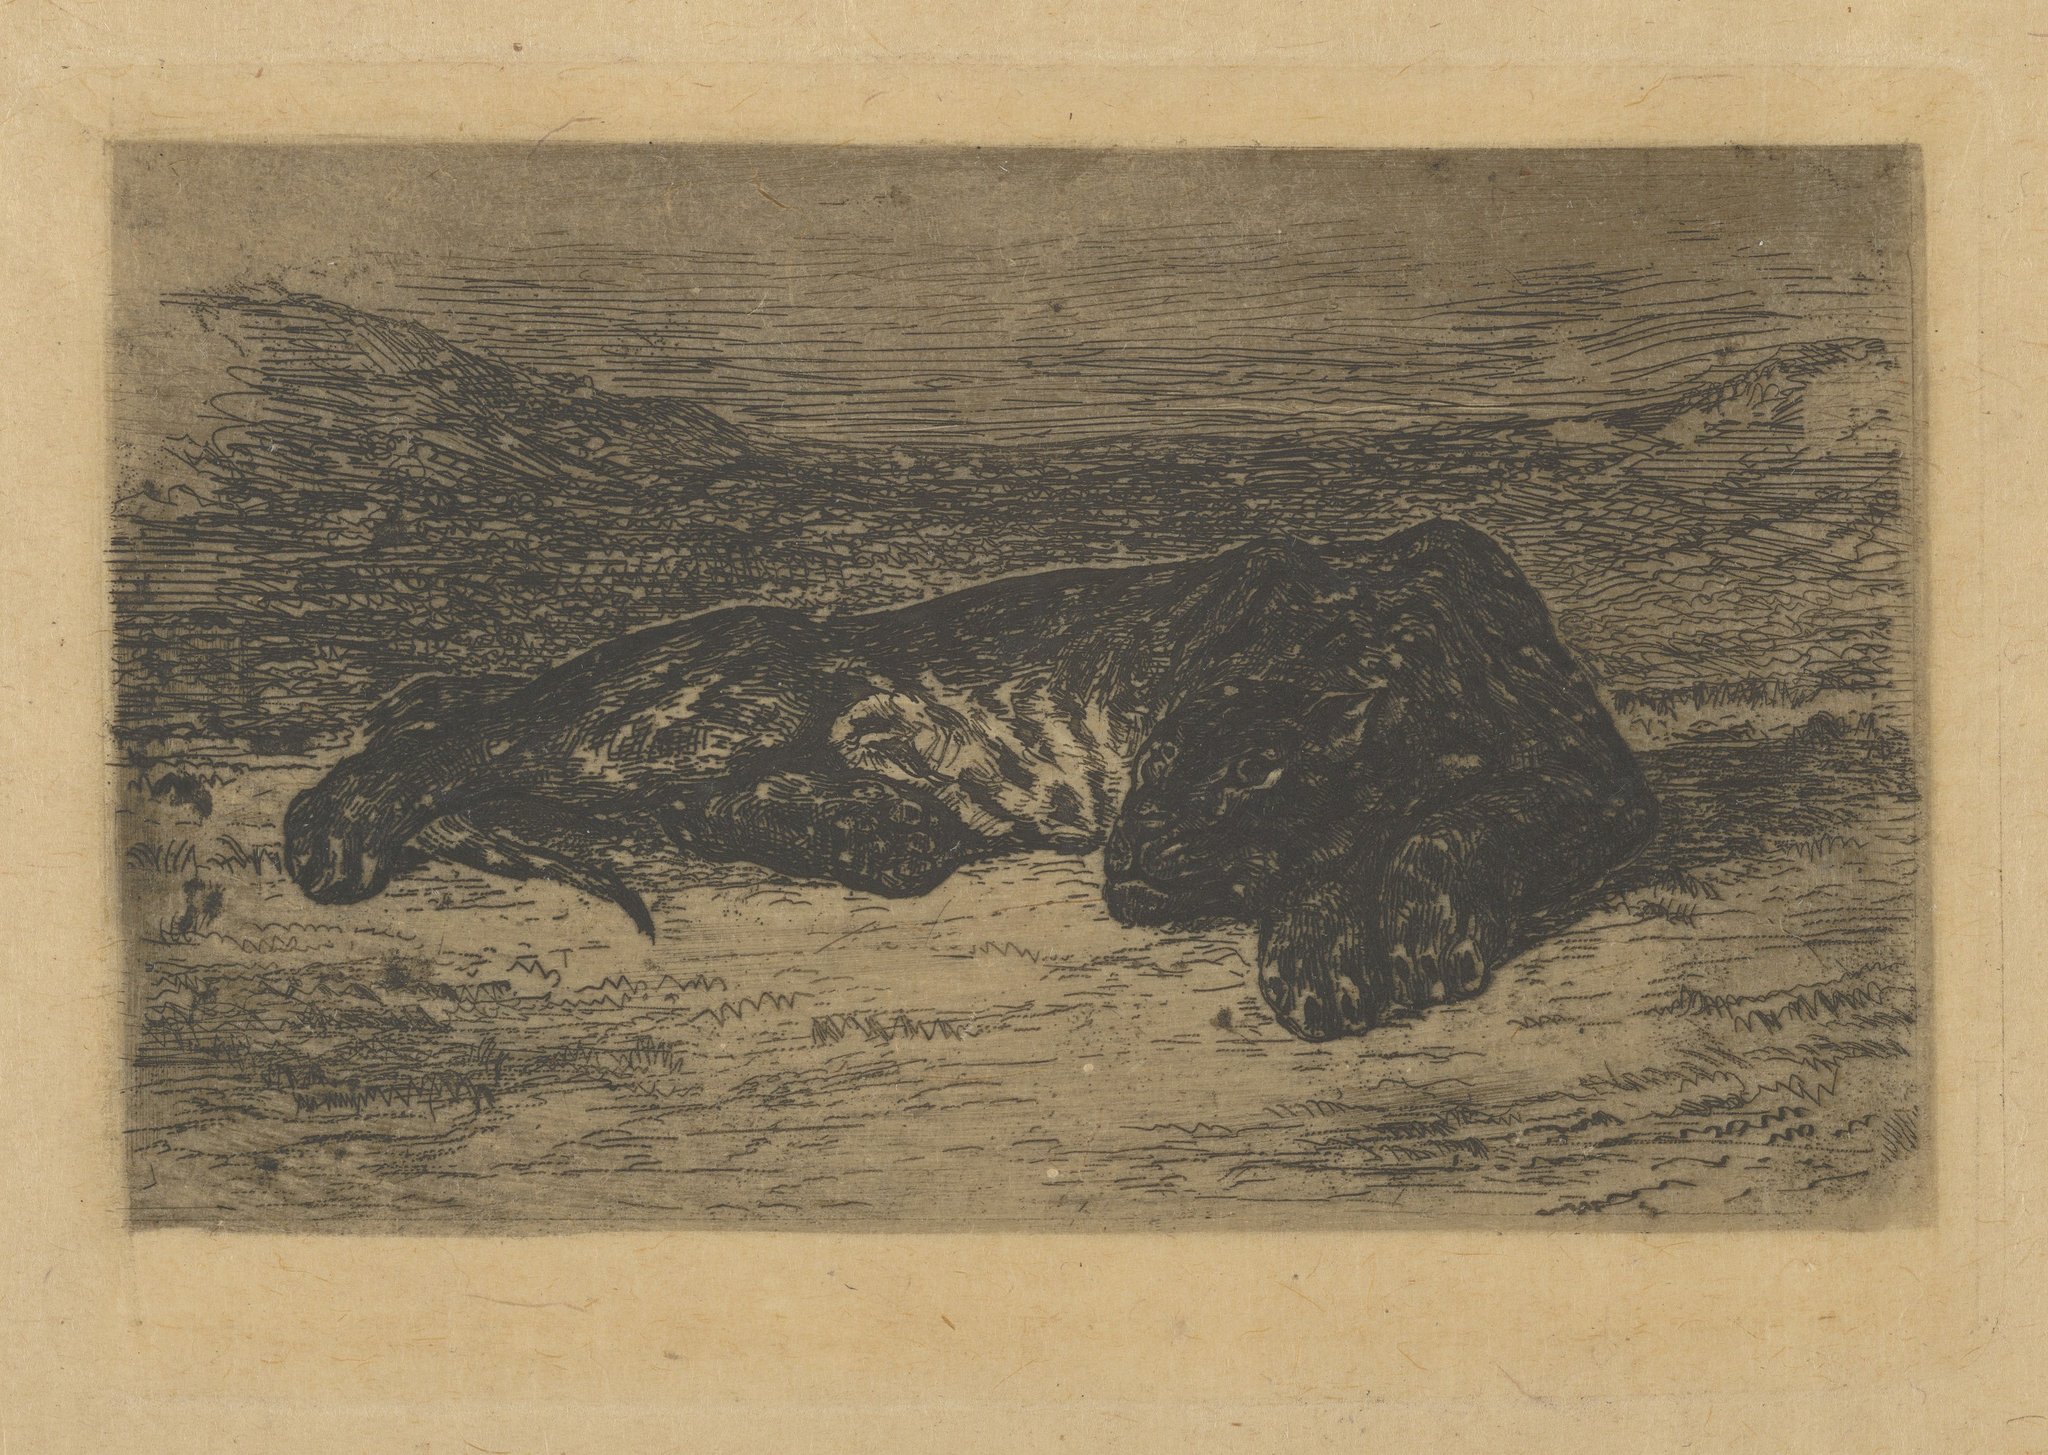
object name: print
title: Tiger Lying in the Desert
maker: eugène delacroix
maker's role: artist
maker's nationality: french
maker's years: 1798-1863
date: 1846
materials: paper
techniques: drypoint, etching, roulette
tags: tigers,deserts